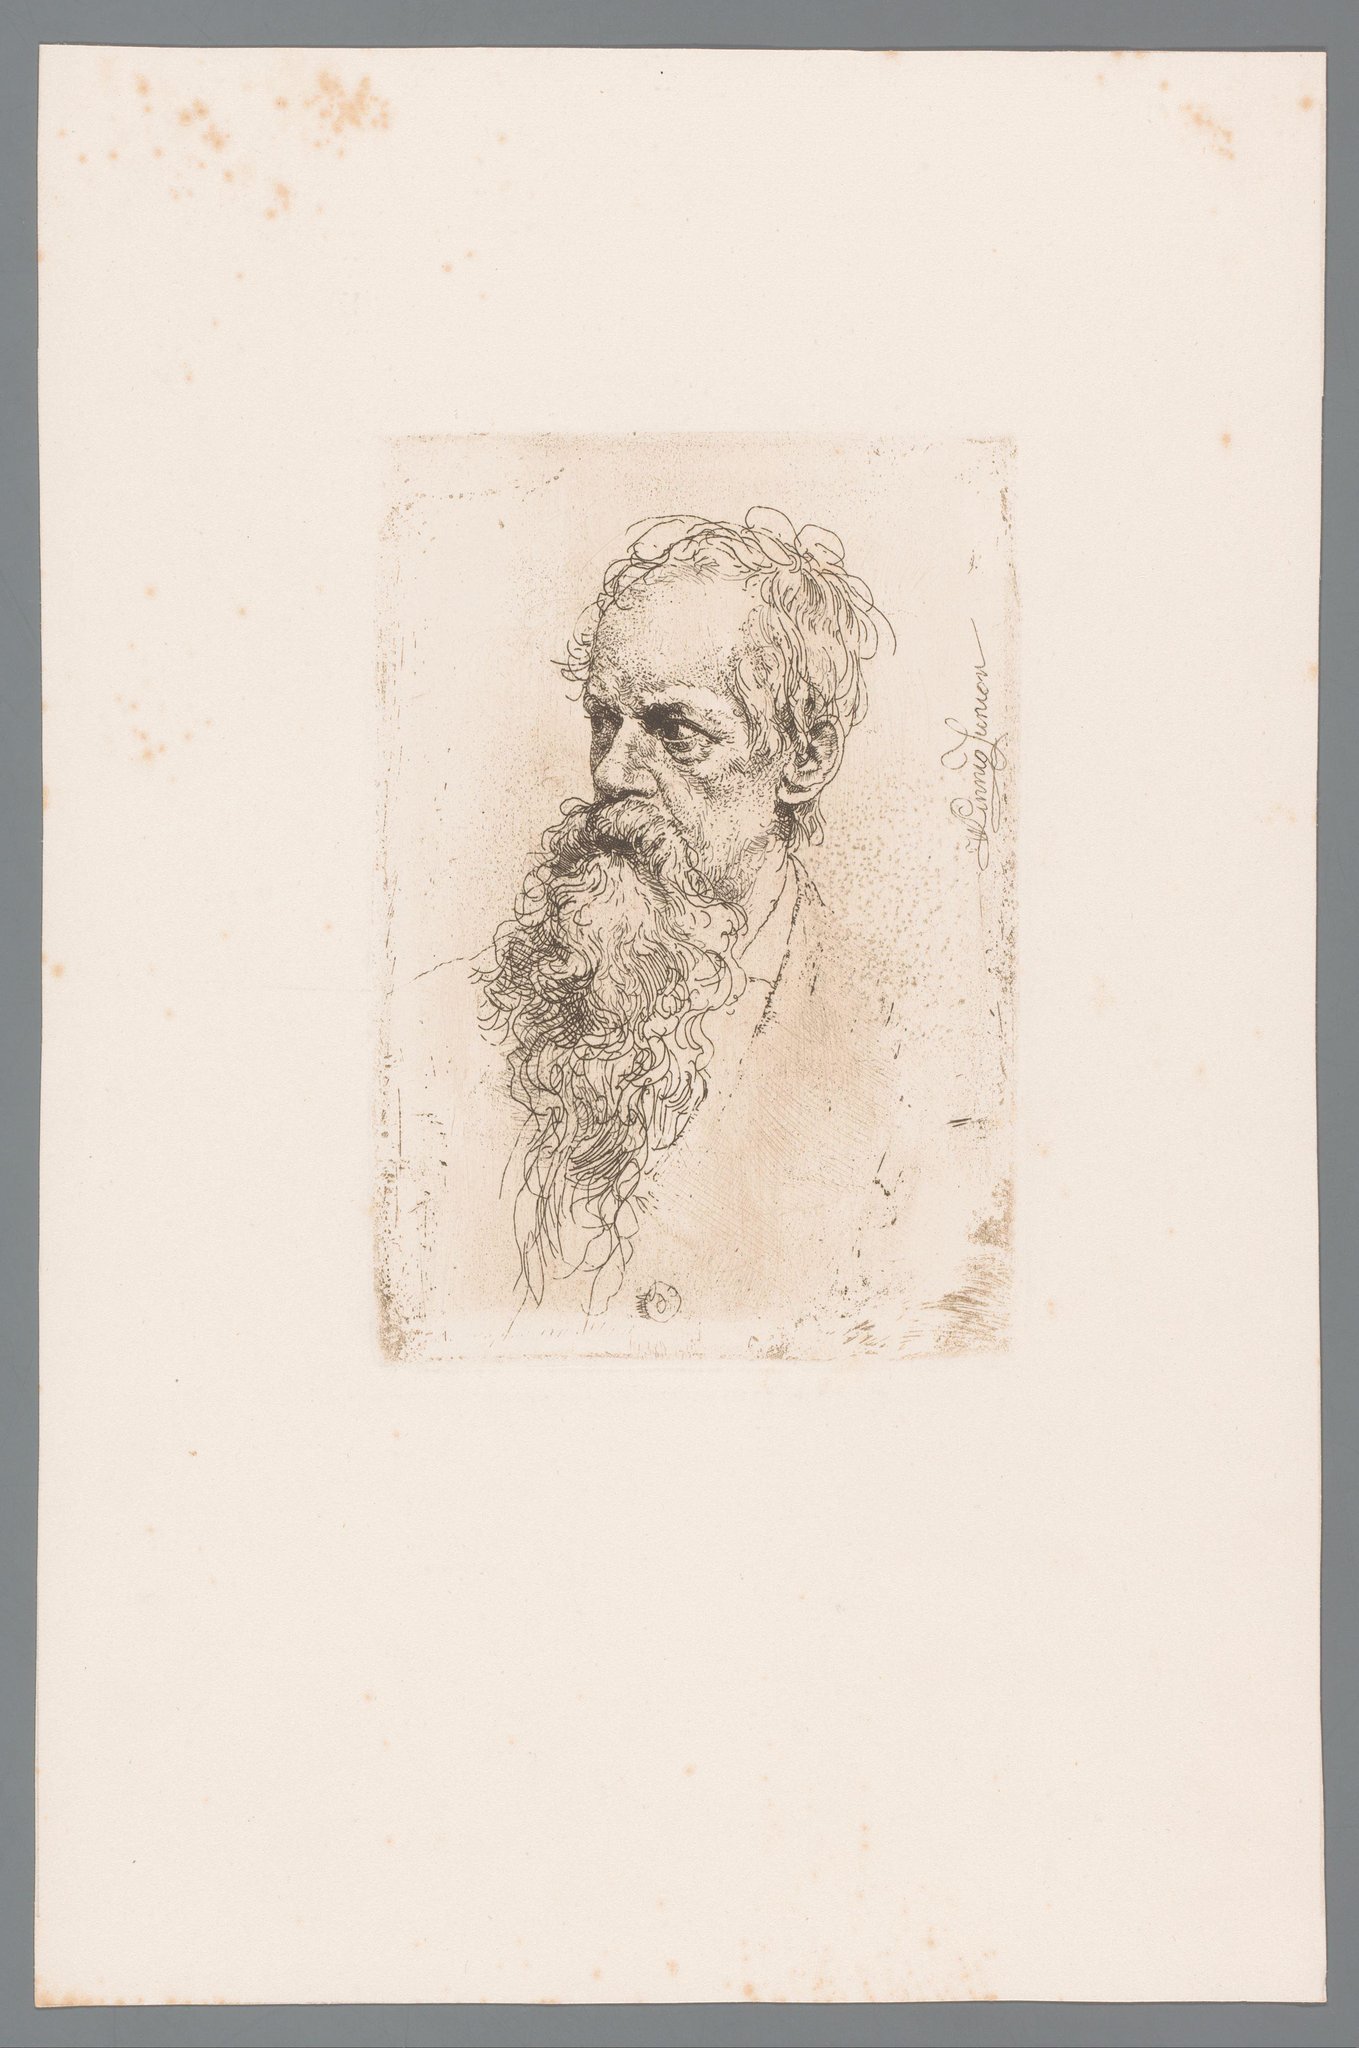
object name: print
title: Portret van Willem Linnig senior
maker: willem linnig (ii)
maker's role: print maker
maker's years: 1842-1890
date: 1852-1890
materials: paper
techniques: etching, intaglio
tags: antwerp, print maker, willem linnig (i), historical persons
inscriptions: collector's mark: Lugt 2228